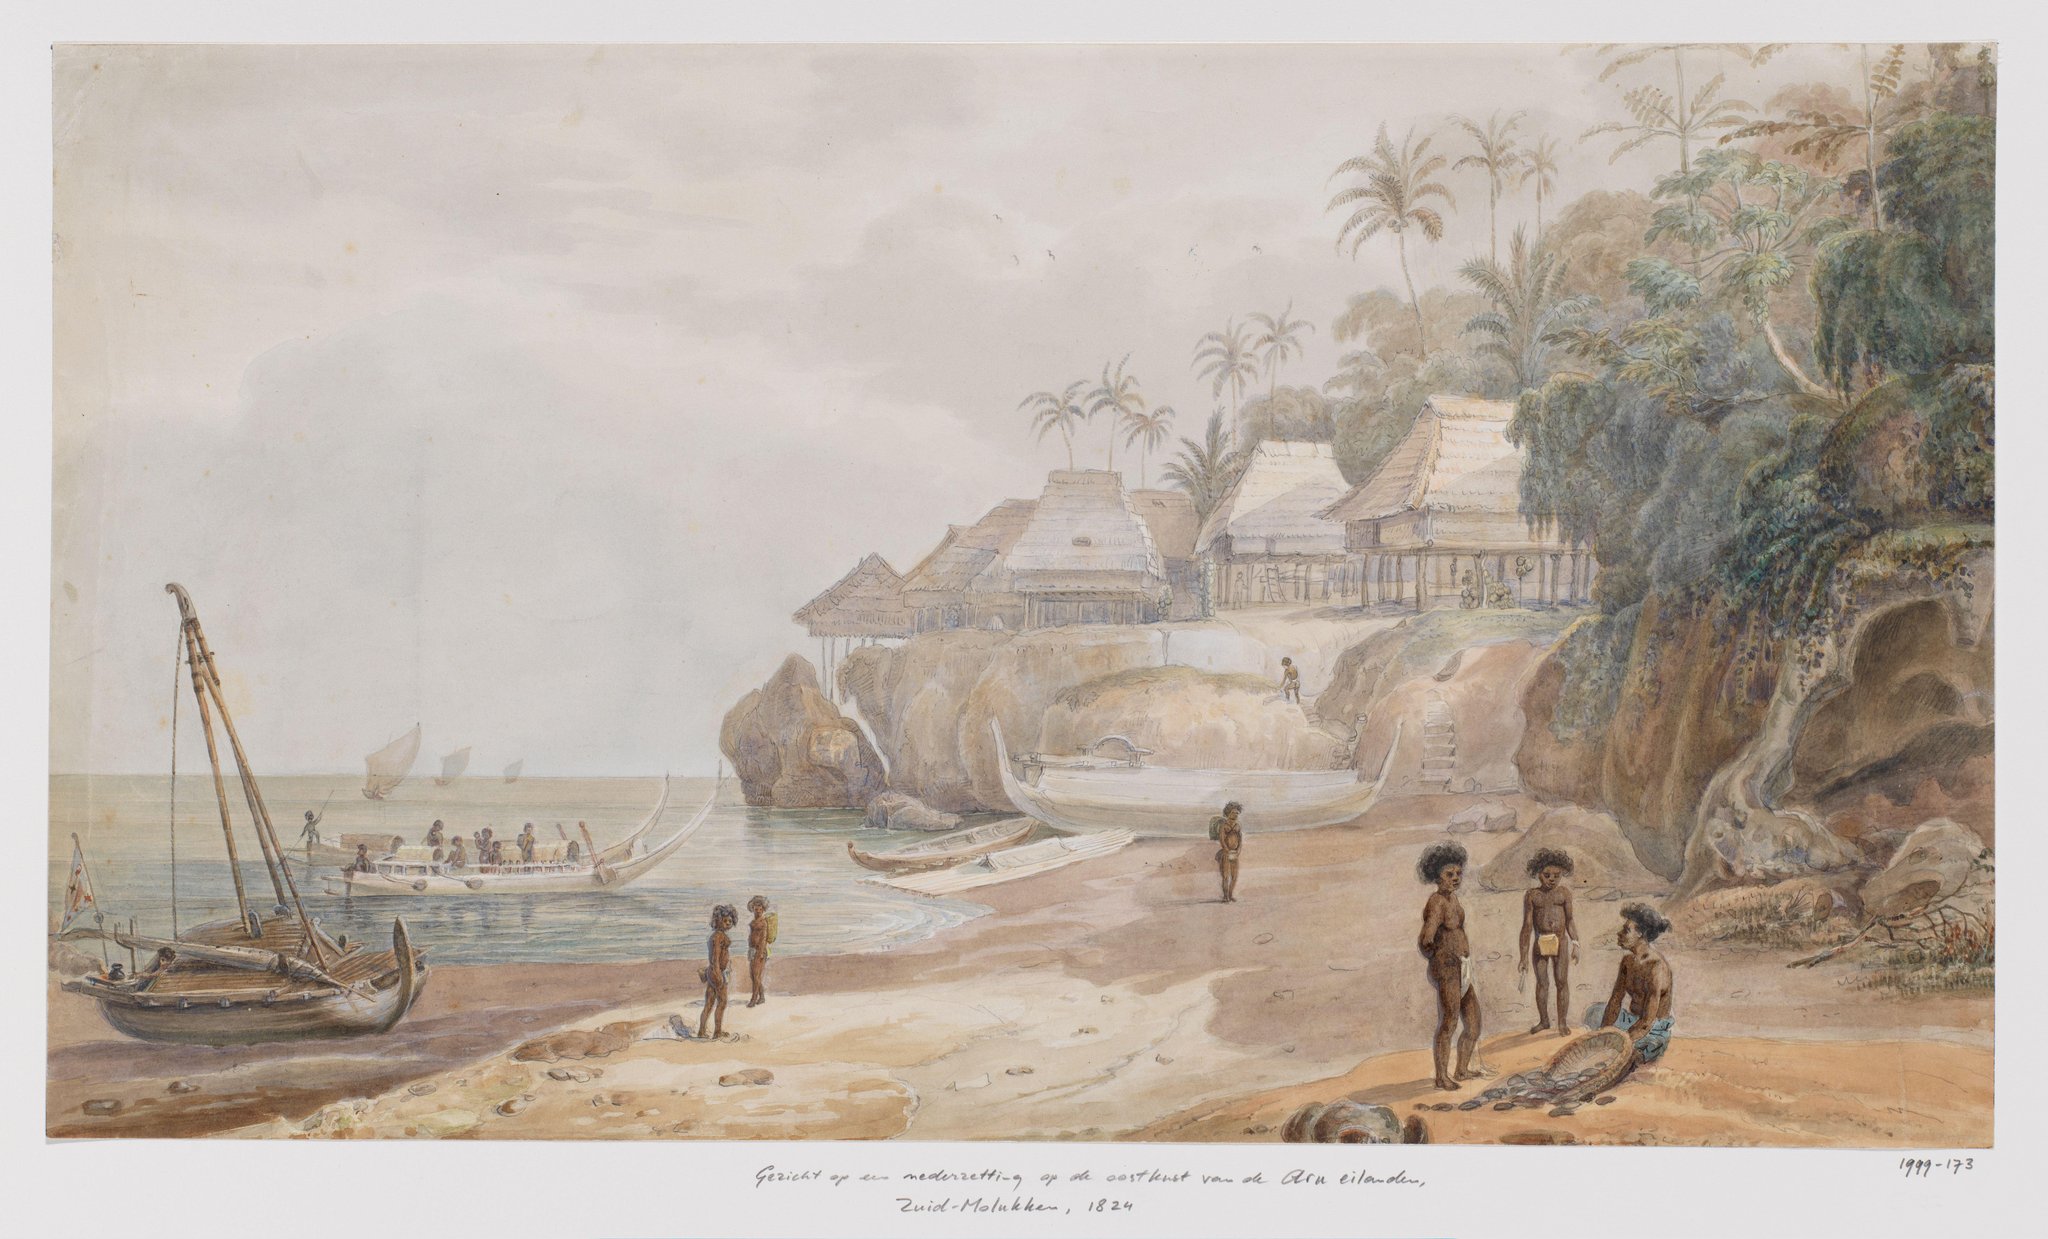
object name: topographical view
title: Gezicht op een Indisch dorp aan zee, mogelijk op een der Aroe-eilanden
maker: adrianus johannes bik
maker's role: draughtsman, print maker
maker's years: 1790-1872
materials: ink, paper, watercolor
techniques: brush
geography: aru-eilanden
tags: aru-eilanden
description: Het gezicht is waarschijnlijk de kampung Afara op het eiland Workai; komt overeen met de beschrijving van Bik die er van 24 tot 28 april 1824 vertoefde.